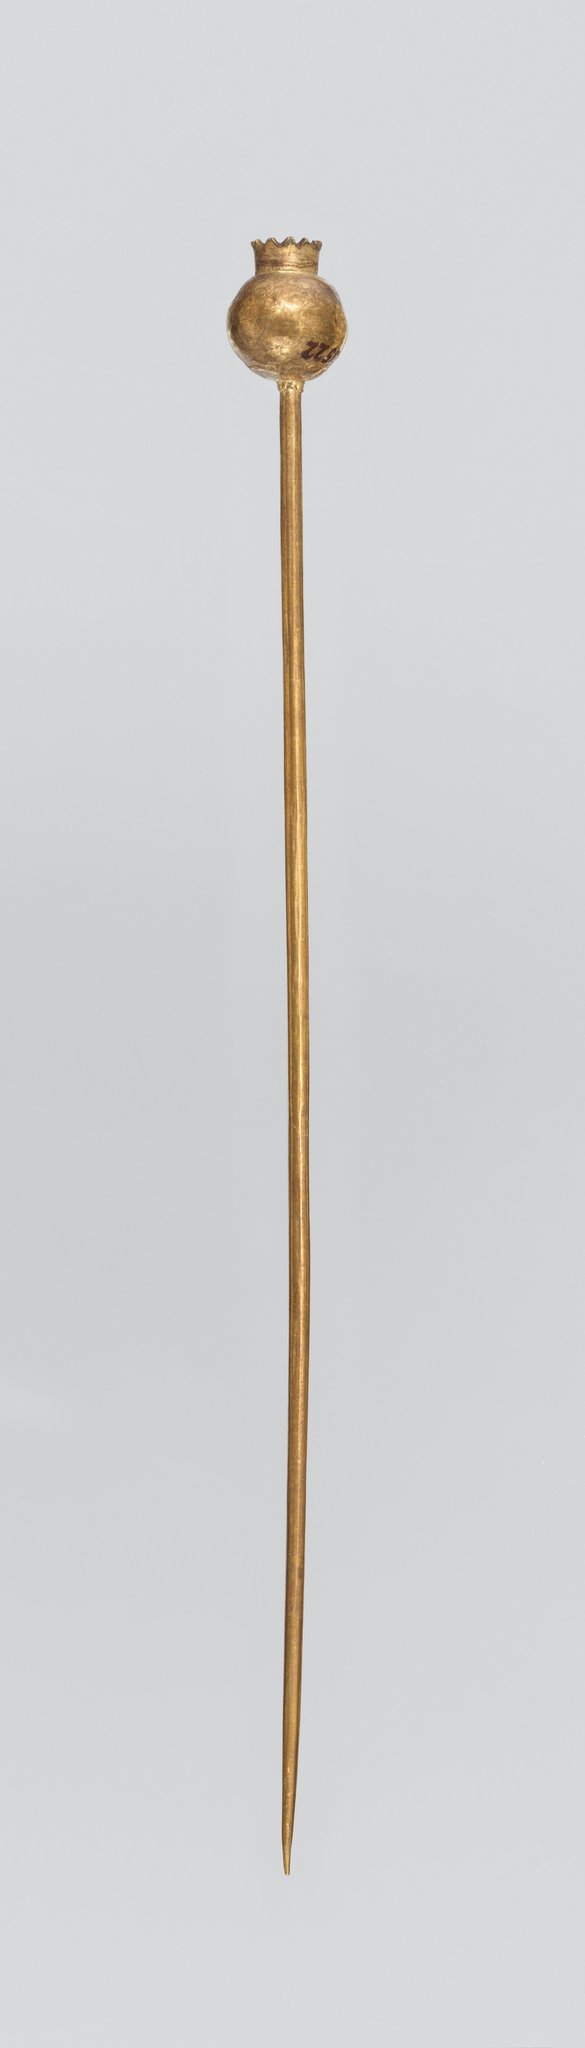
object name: pin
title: Gold pin with pomegranate head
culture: greek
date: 700-501 BCE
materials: gold, silver